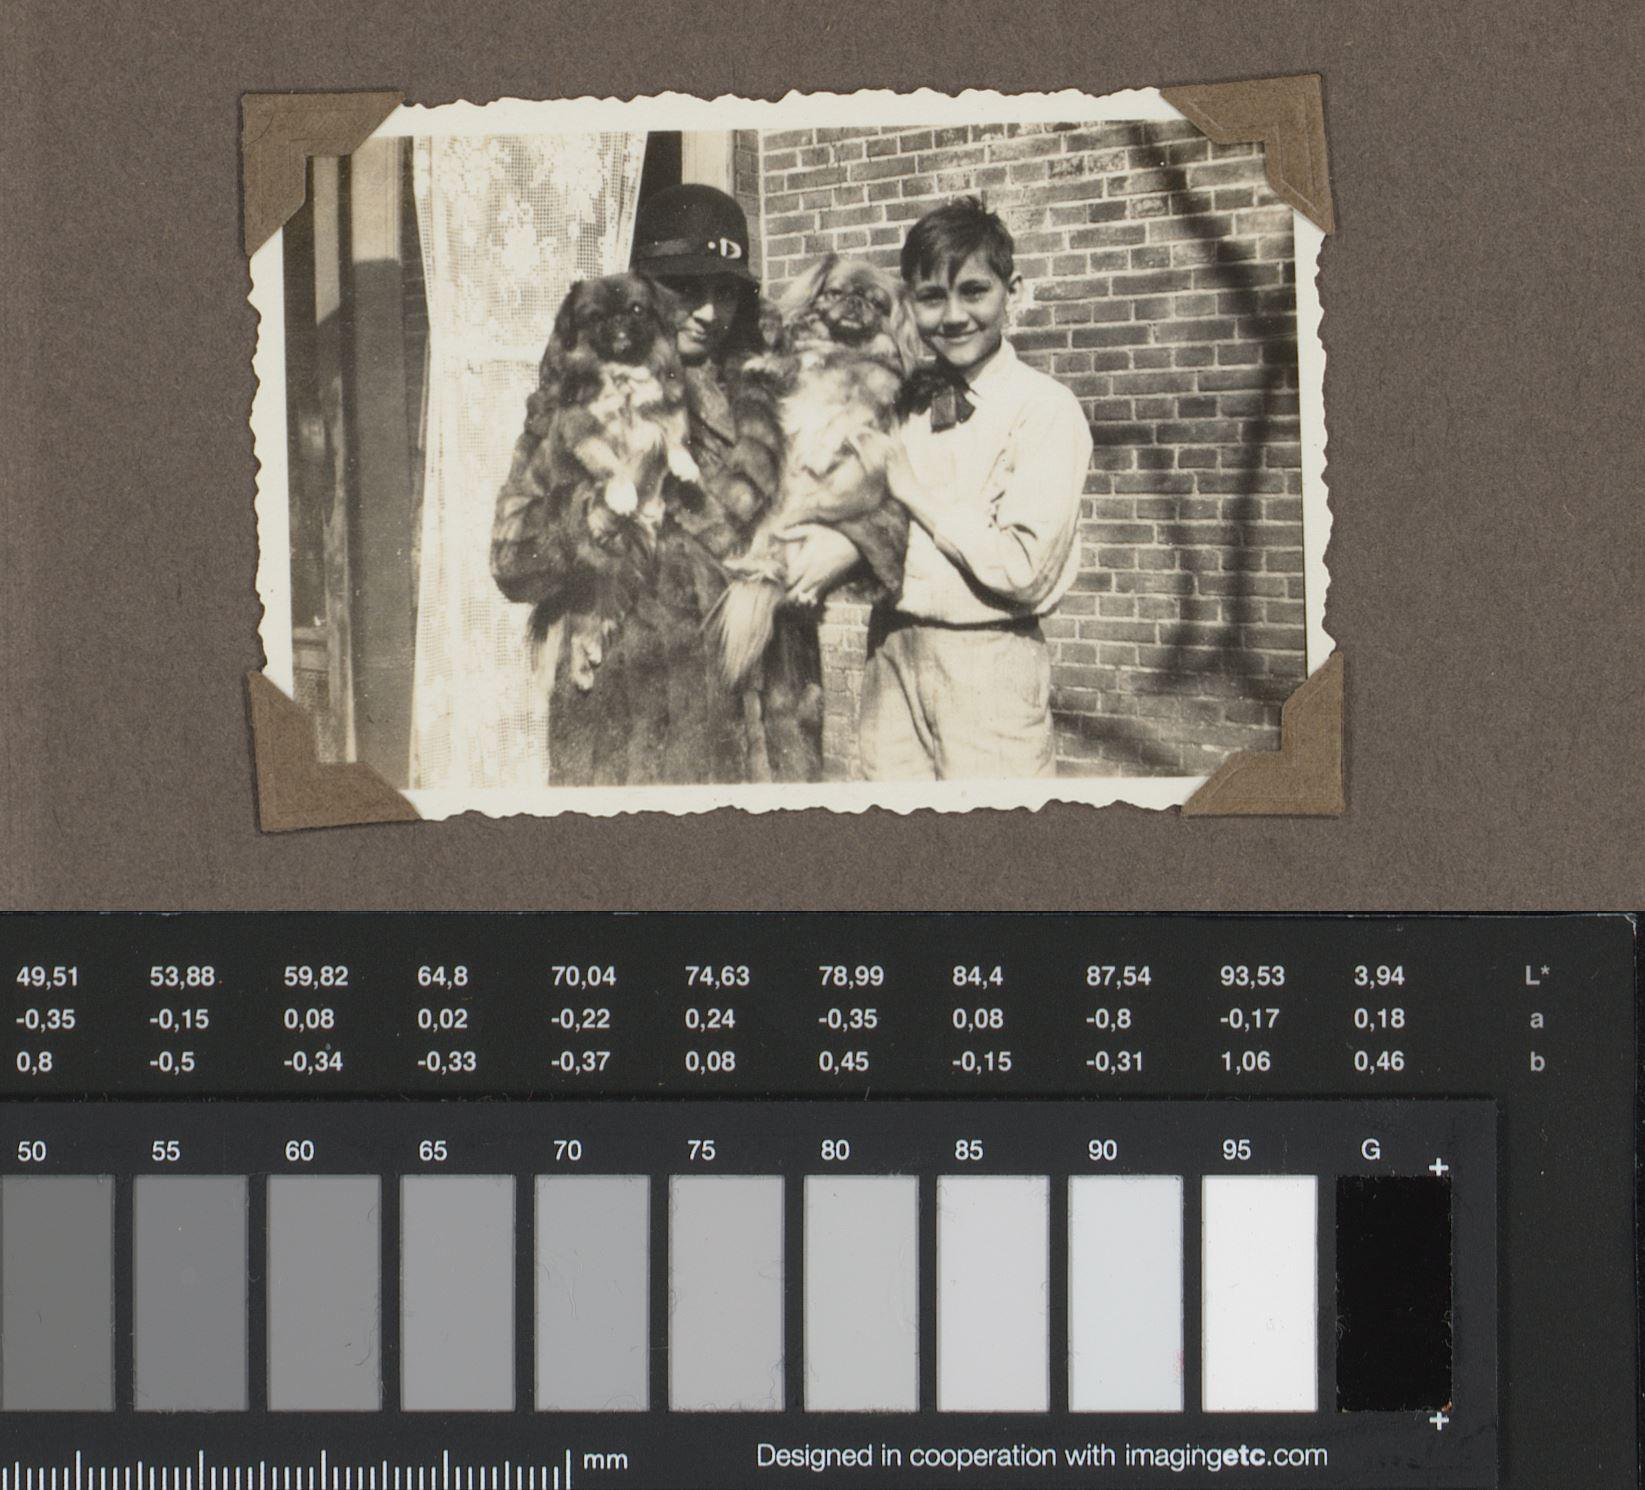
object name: photograph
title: Henriëtte Wassink en Dicky Baud met twee honden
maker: Anonymous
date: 1930-1935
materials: paper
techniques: gelatin silver print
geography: netherlands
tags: batavia, the hague, henriëtte wassink, adult woman, boy (child between toddler and youth), historical persons, dog, netherlands